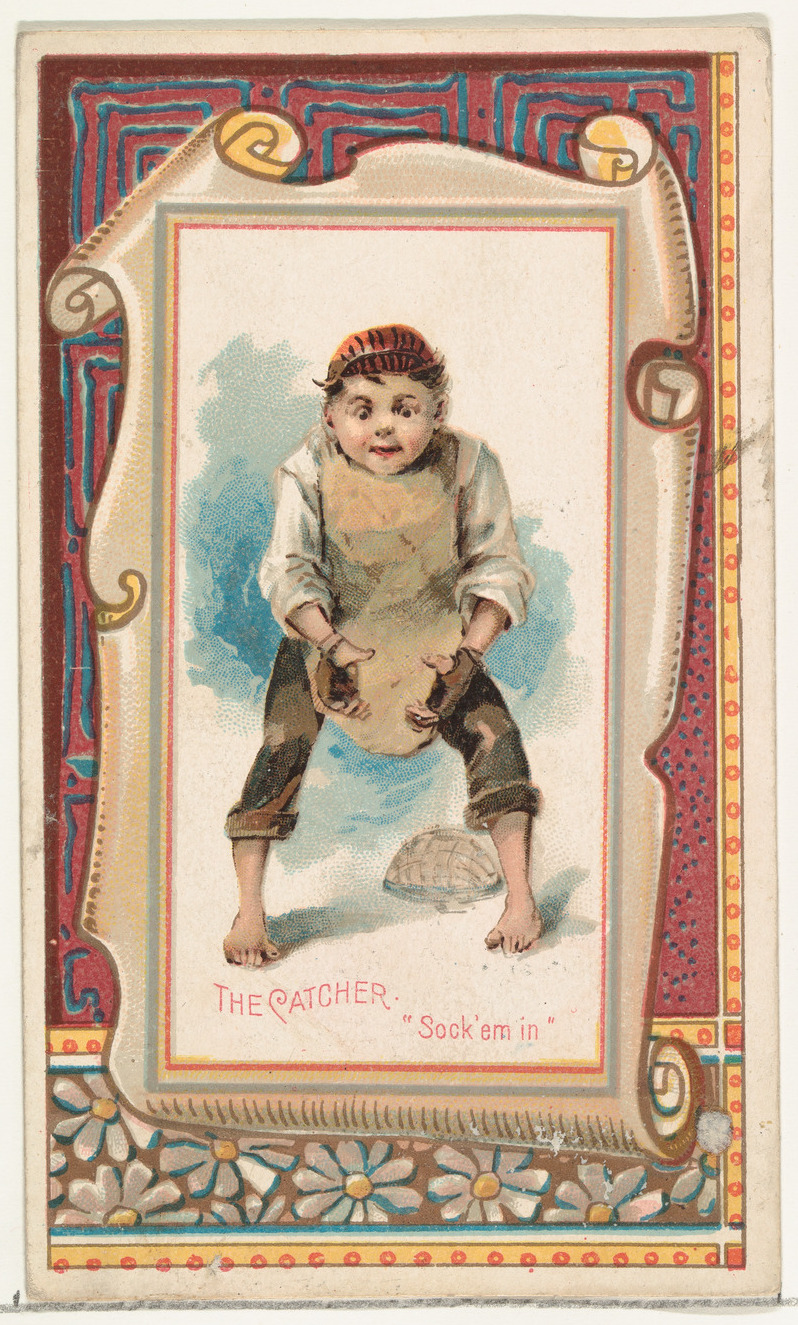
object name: print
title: The Catcher, "Sock 'em in," from the Terrors of America set (N136) issued by Duke Sons & Co. to promote Honest Long Cut Tobacco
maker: w. duke, sons & co.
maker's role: publisher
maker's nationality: american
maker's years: 1870-1920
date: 1888-1889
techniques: color lithograph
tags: boys